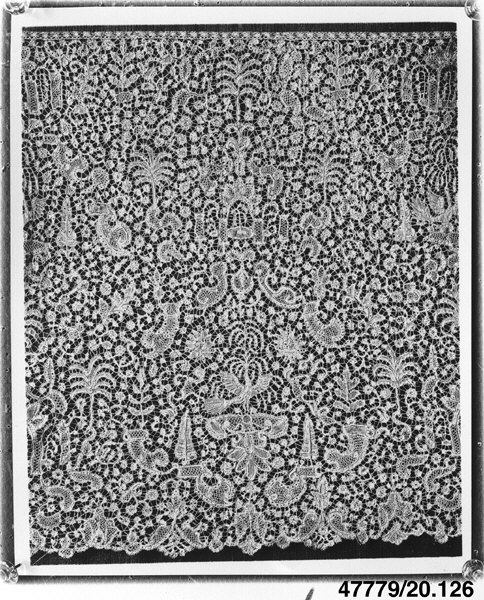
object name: flounce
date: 1701-1733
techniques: lace